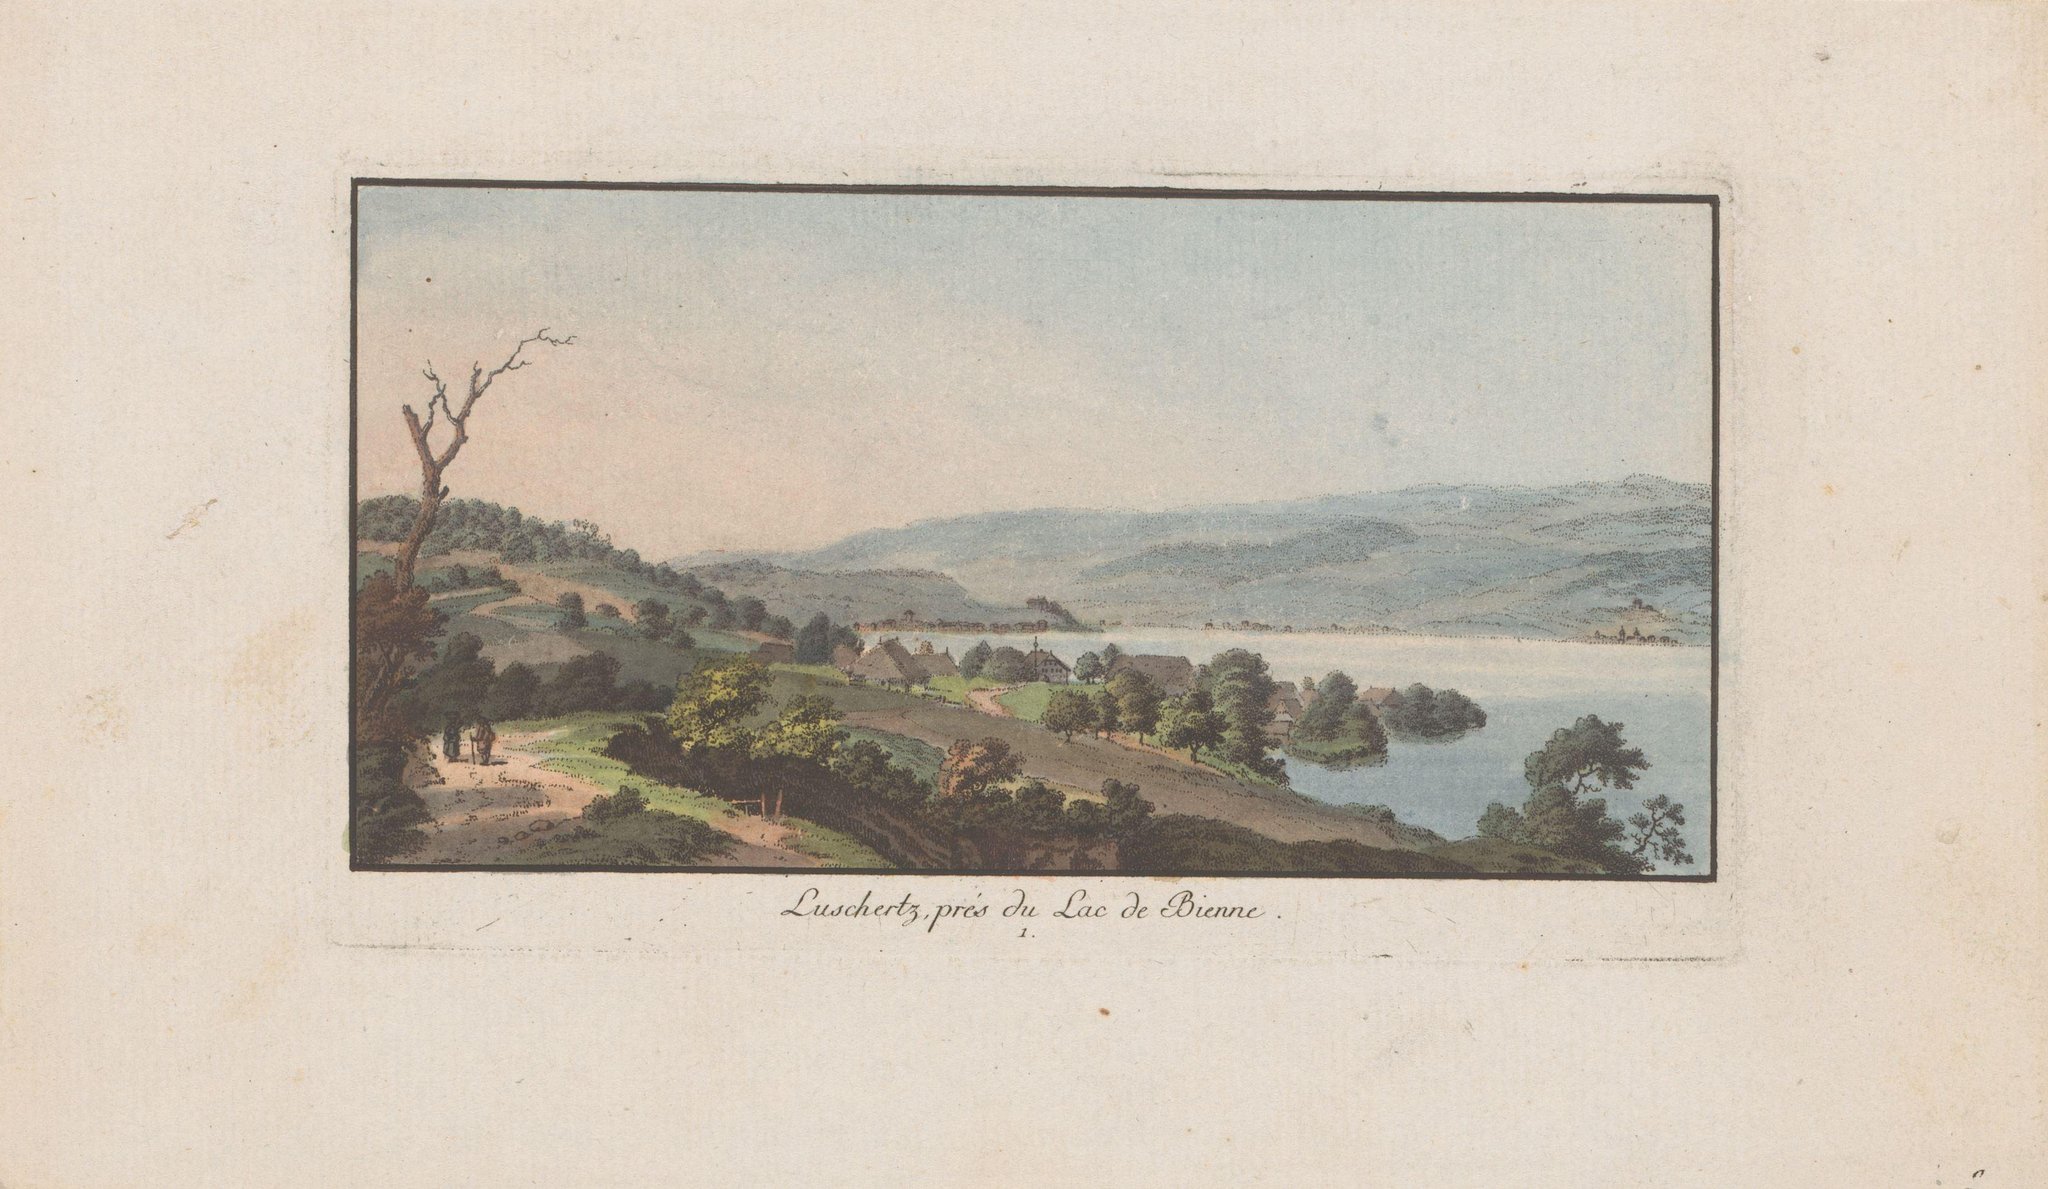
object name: print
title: Sammlung einiger Aussichten in der Schweiz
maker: heinrich rieter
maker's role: print maker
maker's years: 1751-1818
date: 1782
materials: paper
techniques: etching, hand coloring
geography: bern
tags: lake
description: De reeks is gebaseerd op een reis die beide kunstenaars maakten in 1782.